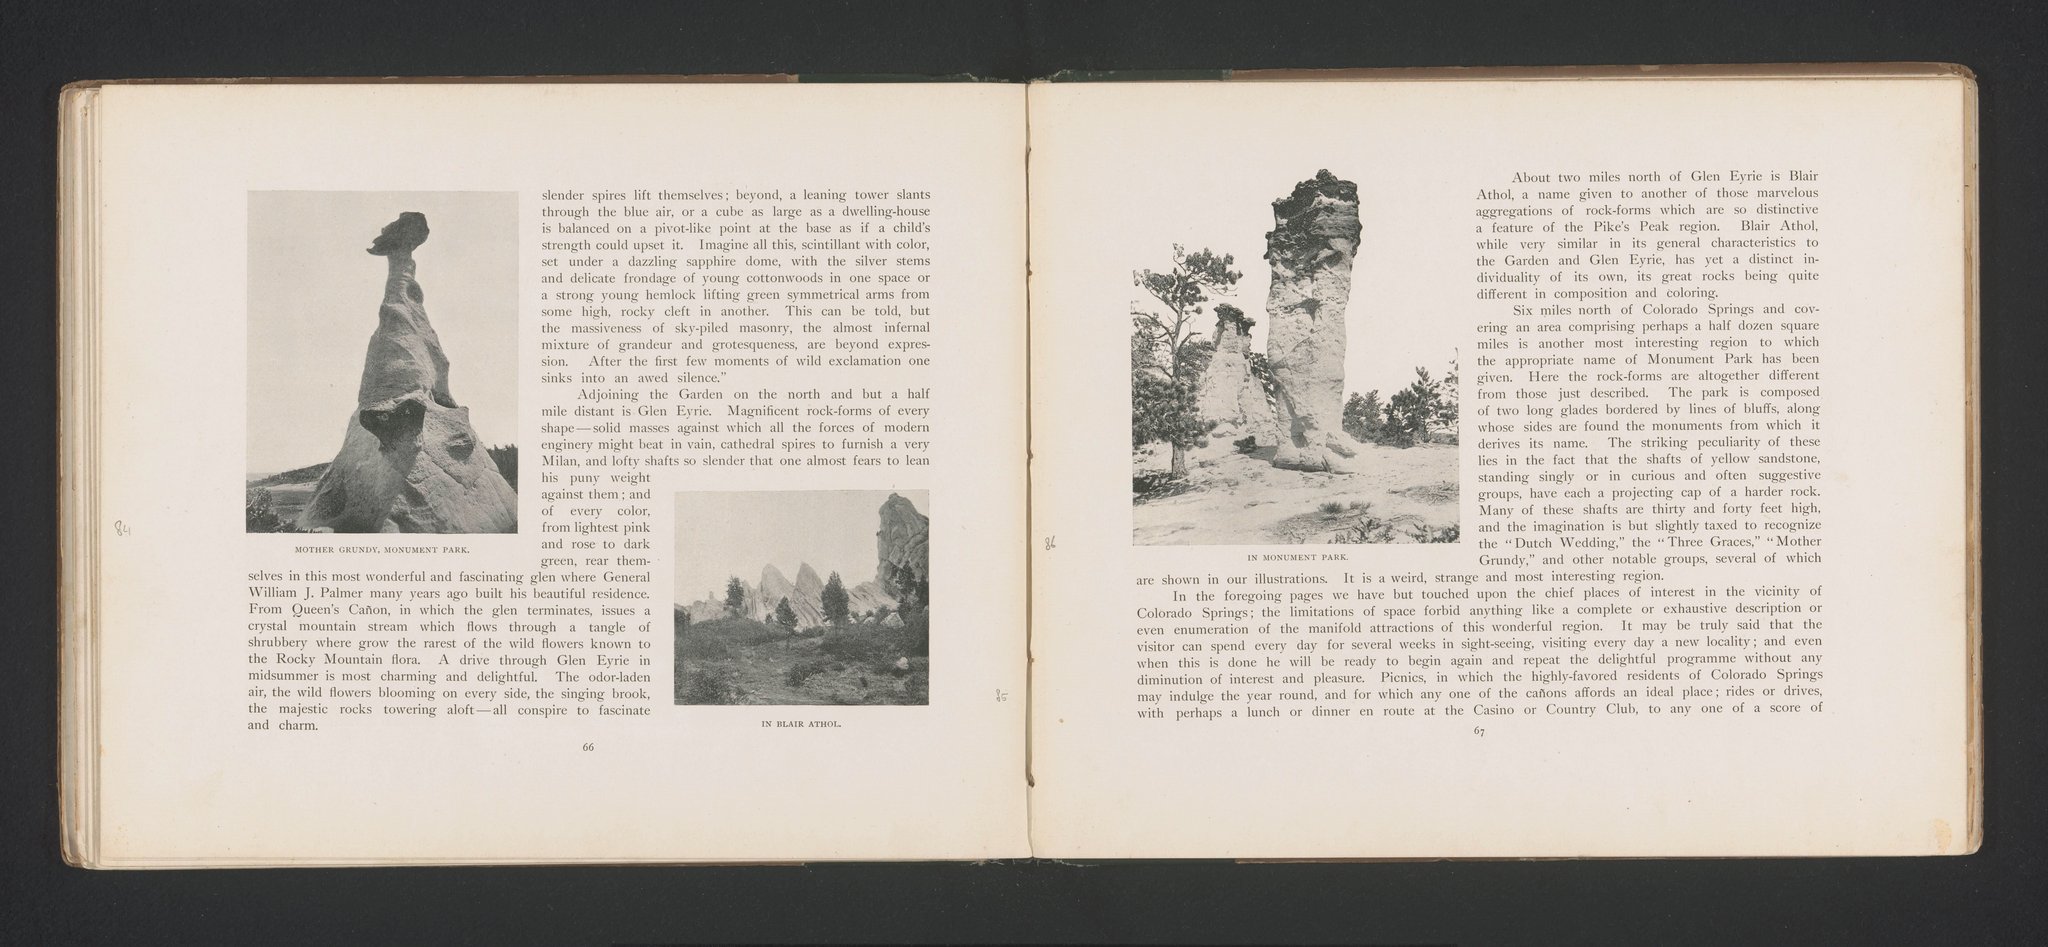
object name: photomechanical print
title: Gezicht op de rotsformatie van Blair Athol nabij Colorado Springs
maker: Anonymous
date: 1888-1893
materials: paper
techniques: autotype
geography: colorado springs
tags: rock-formations